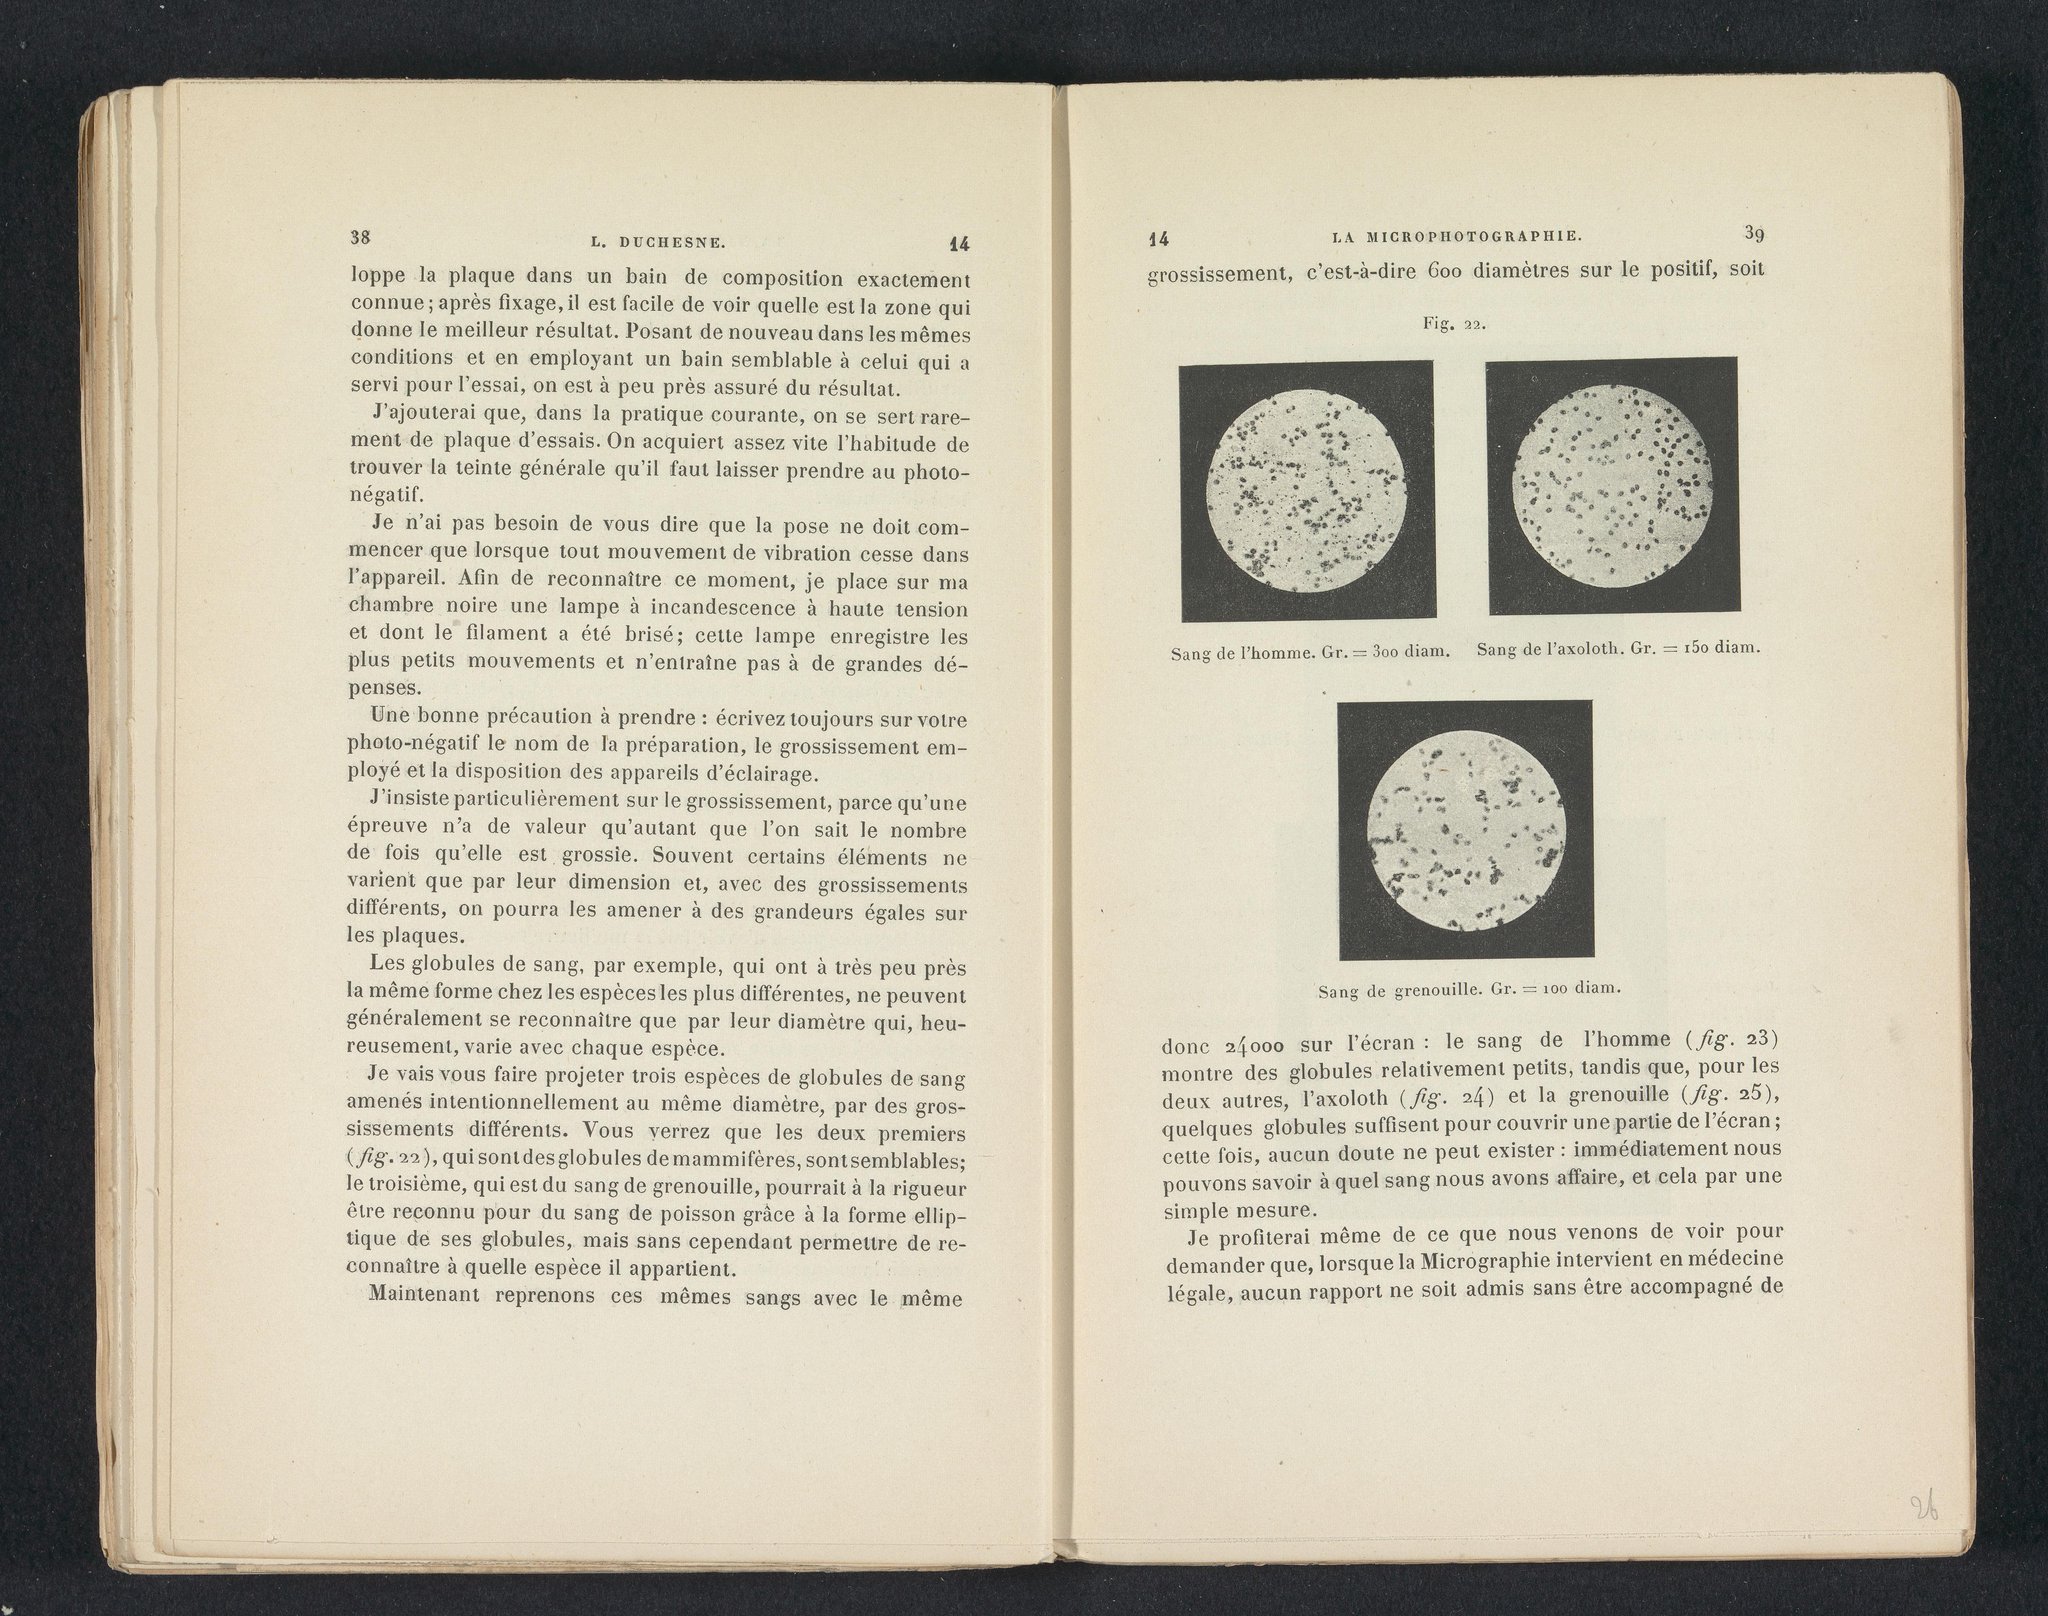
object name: photomechanical print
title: Drie vergrotingen van het bloed van een mens, een axolotl en een kikker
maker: Anonymous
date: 1883-1893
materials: paper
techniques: autotype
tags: tailless amphibians: frog, blood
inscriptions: number: ‘Fig. 22.’, inscription: ‘Sang de l'homme (...) Gr. = 100 diam.’